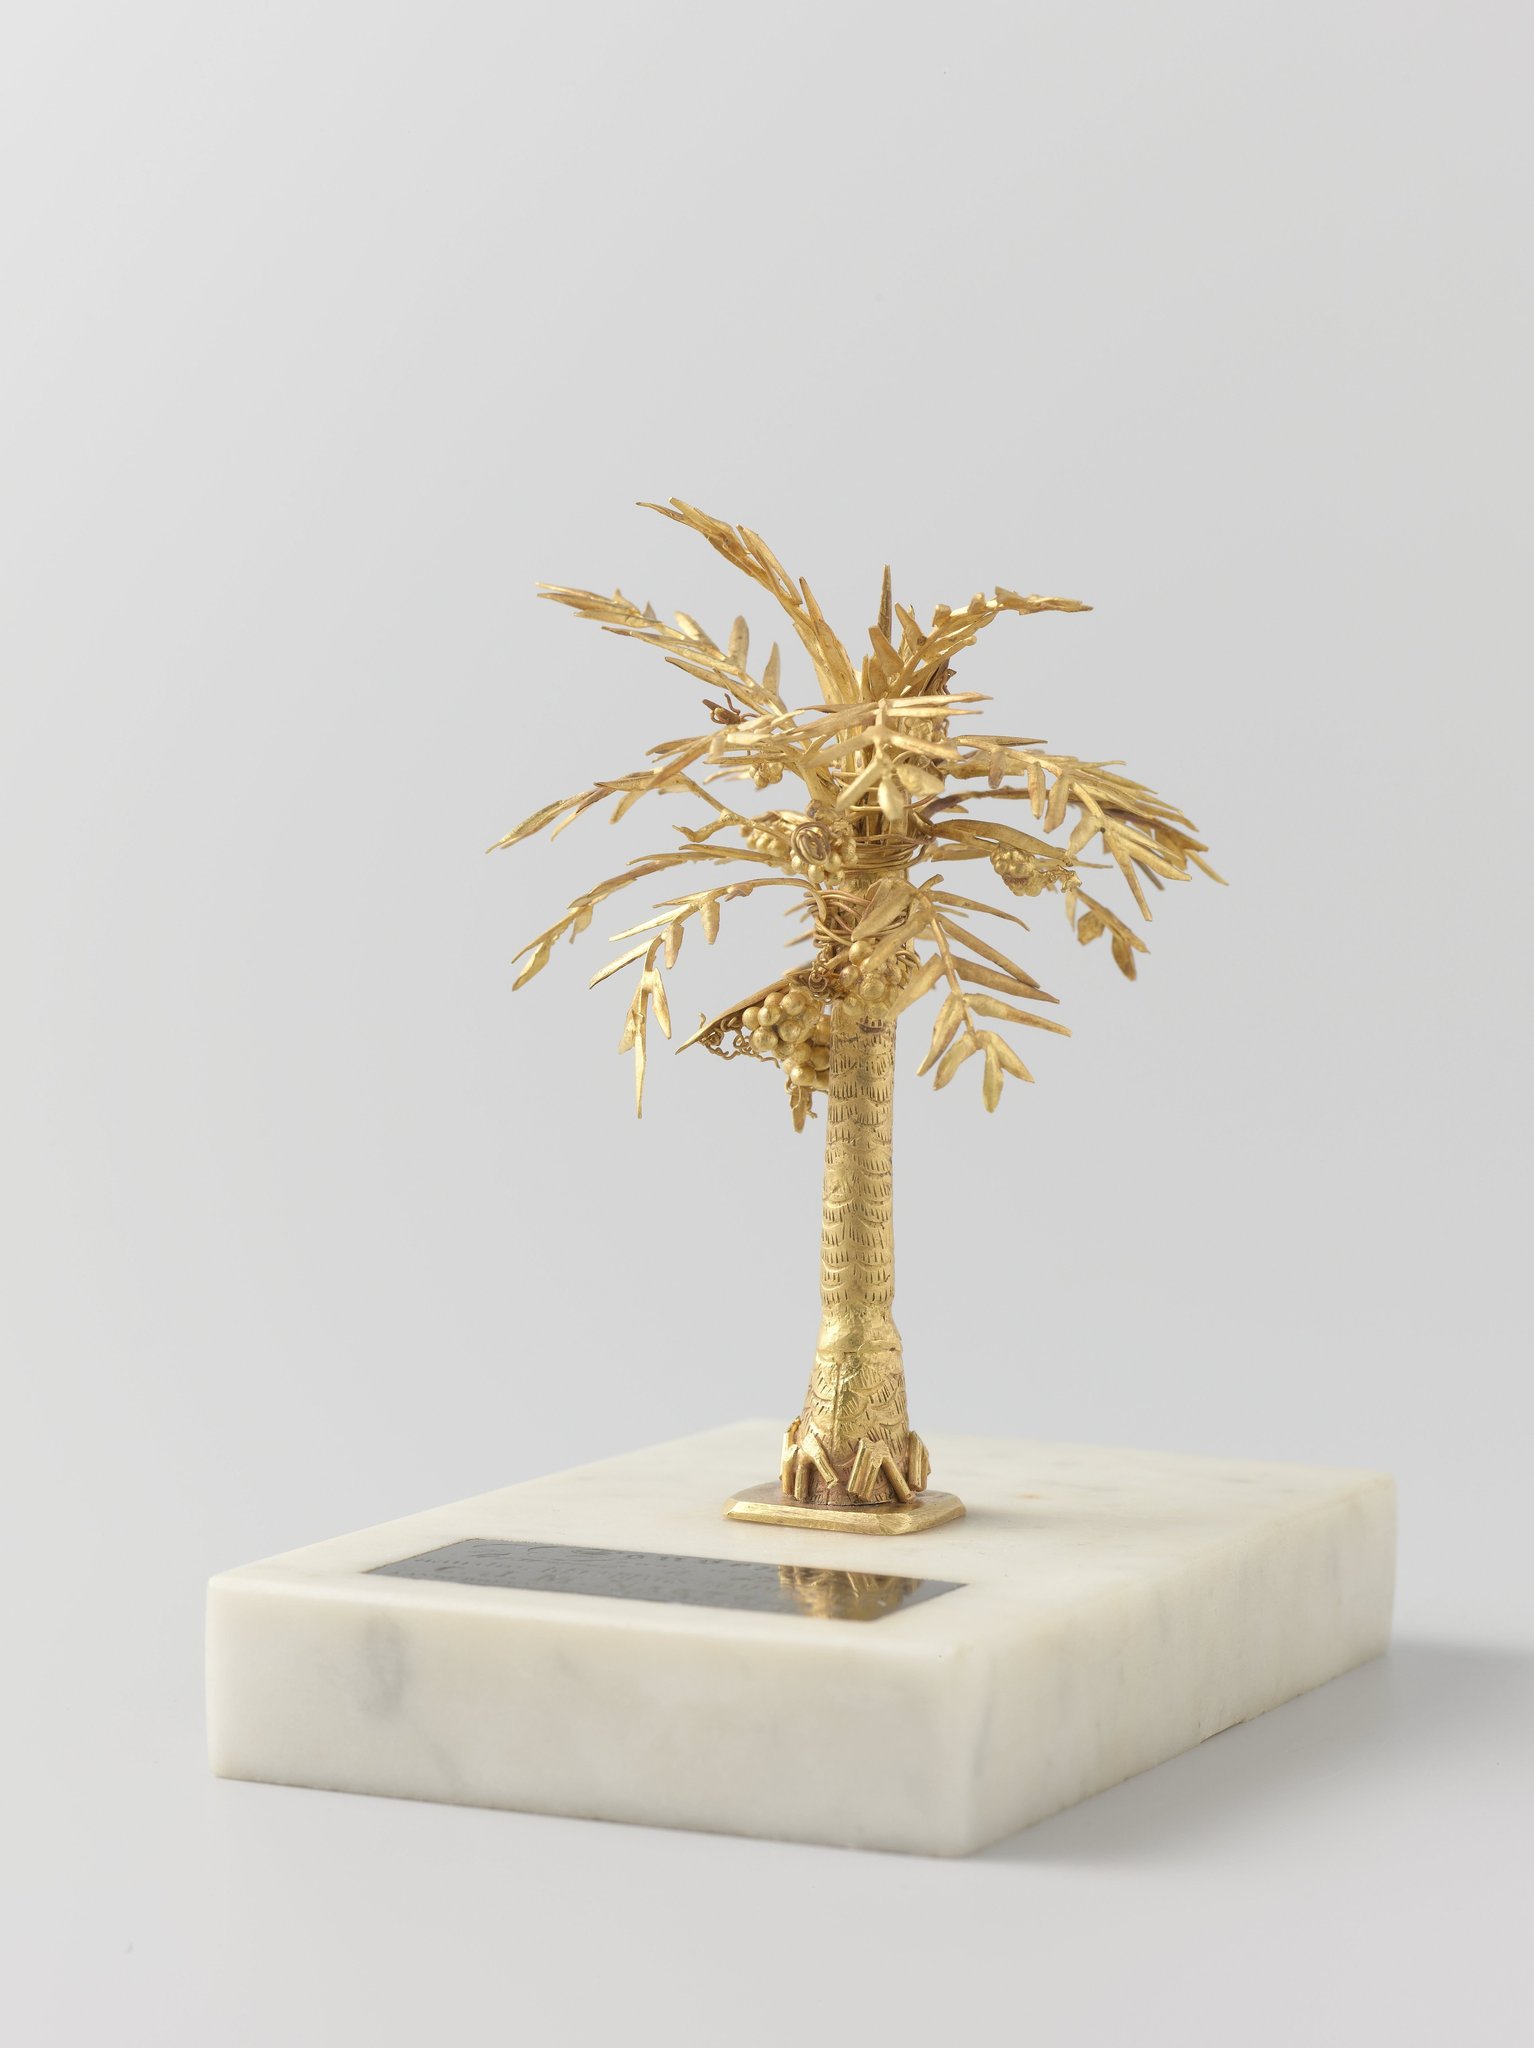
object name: miniature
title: Palmboom geschonken aan C.J.M. Nagtglas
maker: Anonymous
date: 1871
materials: gold, marble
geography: elmina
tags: gouverneur, c.j.m. nagtglas, elmina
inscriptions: inscription: ‘Souvenir door het personeel te Elmina aan den regeringscommissaris C.J.M. Nagtglas aangeboden den 8en Juny 1871.’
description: Miniatuur van goud in de vorm van een palmboom. Op het rechthoekige marmeren voetstuk zit een bronzen plaatje met opschrift.